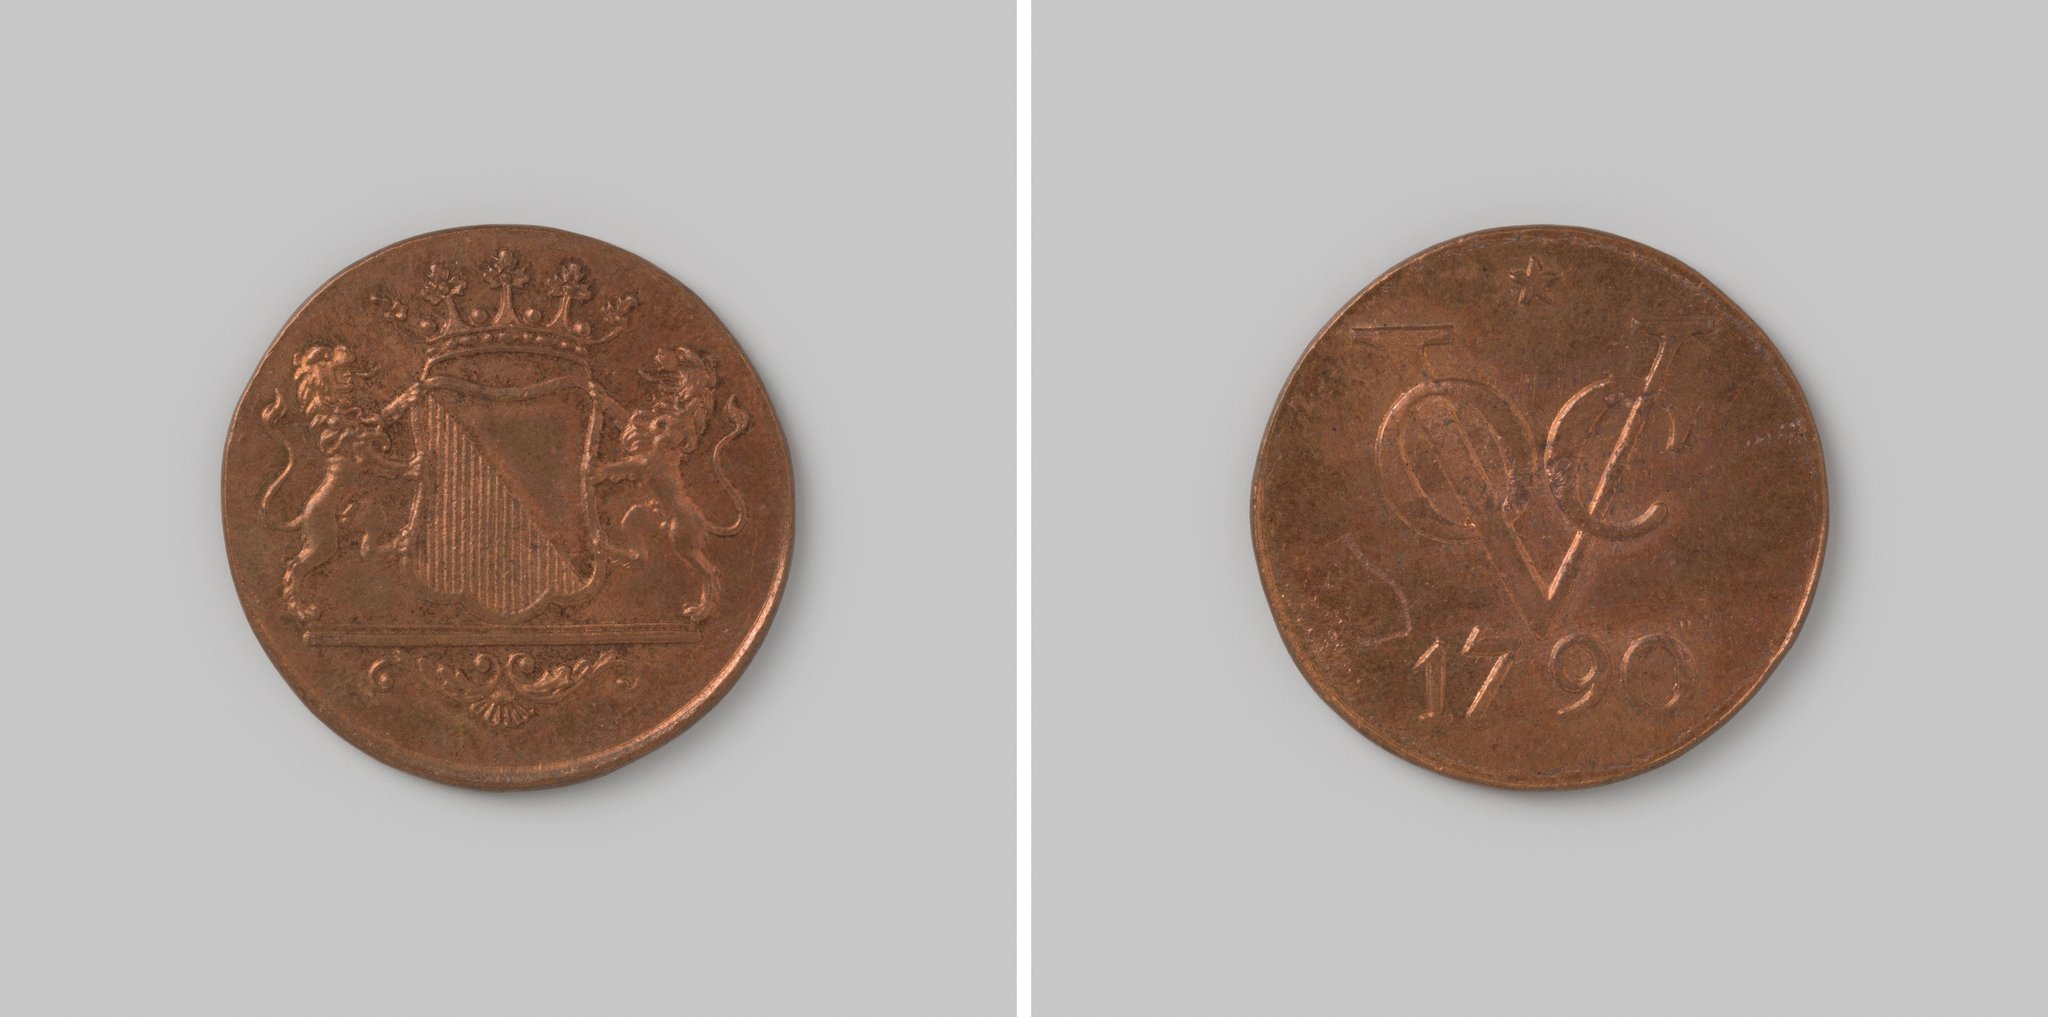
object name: coin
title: Dubbele duit op naam van de VOC en de stad Utrecht met jaartal1790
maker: william ii of the netherlands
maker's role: koning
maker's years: 1792-1849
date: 1840-1843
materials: copper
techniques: striking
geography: surabaya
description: Koperen munt. Voorzijde: op balk, waaronder guirlande, staand, door twee leeuwen gehouden gekroond wapenschild van de stad Utrecht. Keerzijde: monogram van de VOC, waarboven muntteken ster en waaronder fictief jaartal 1790. Gladde rand.